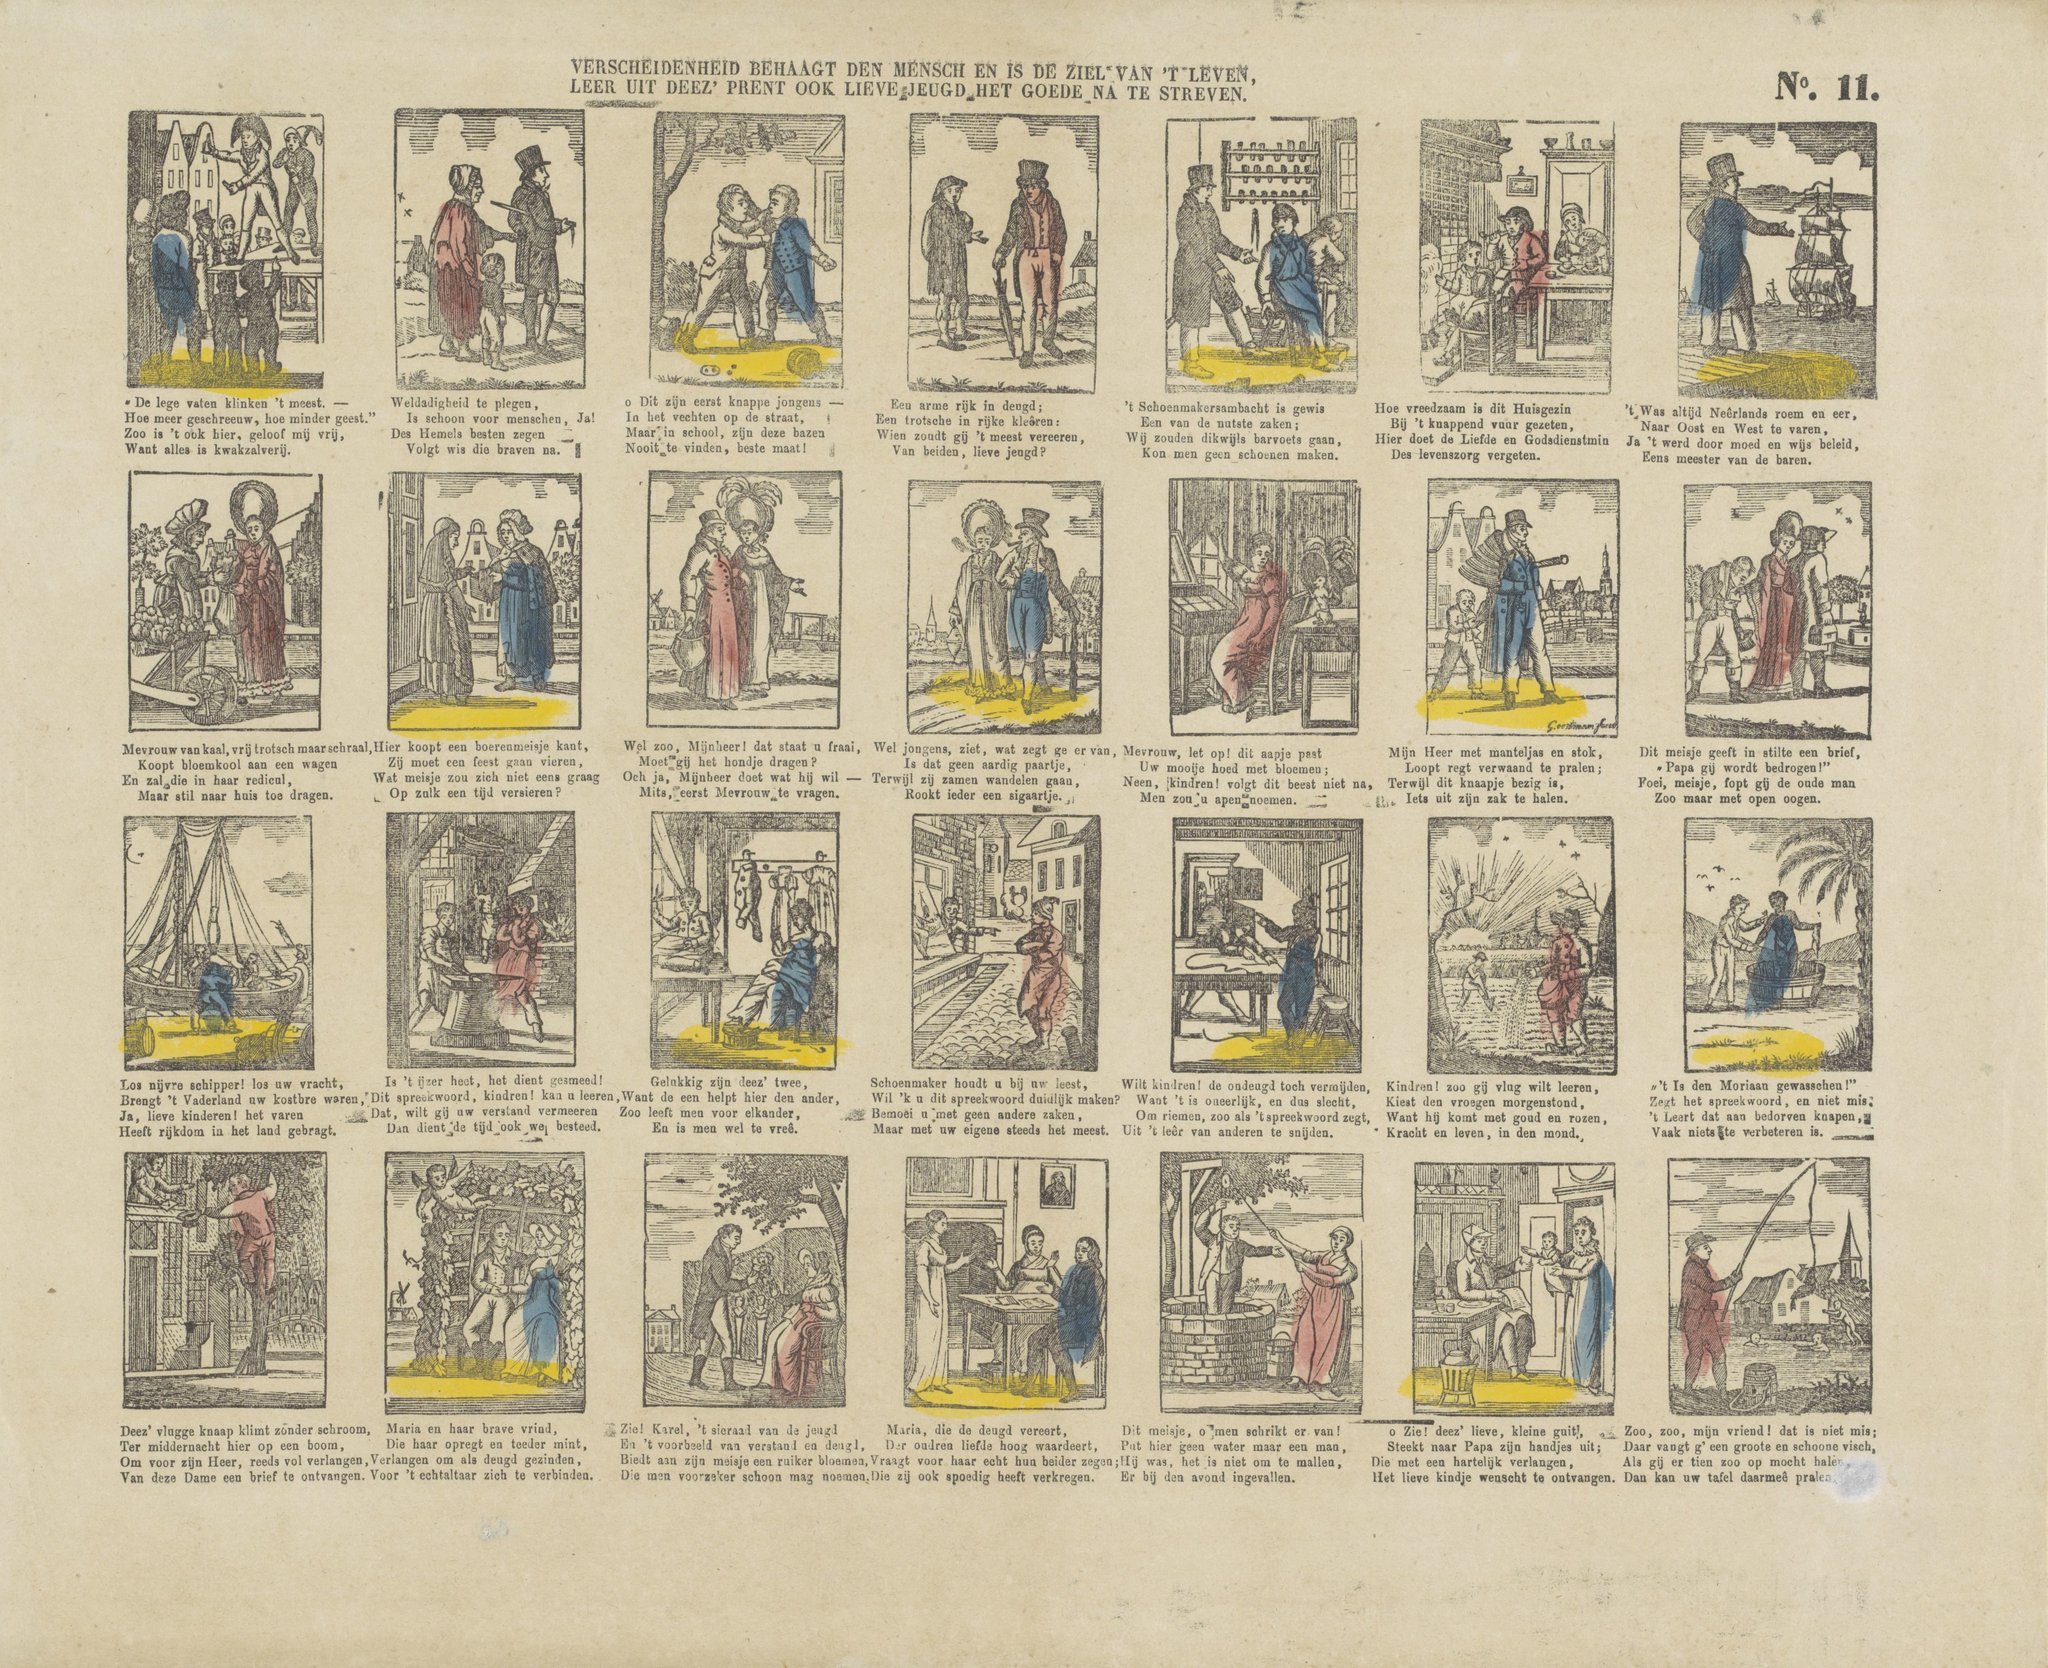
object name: print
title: Verscheidenheid behaagt den mensch / En is de ziel van 't leven, / Leer uit deez' prent ook lieve jeugd, / Het goede na te sneven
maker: gerrit oortman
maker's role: print maker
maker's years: 1781-1822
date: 1850-1870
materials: paper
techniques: colour, letterpress printing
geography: netherlands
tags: craft-production, skilled handiwork, farmers, working class, labourers, crafts and industries, fighting, seaman: sailor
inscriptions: collector's mark: Lugt 2760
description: Blad met 28 voorstellingen van verschillende beroepen en bezigheden. Onder elke voorstelling een vers. Rechtsboven genummerd: No. 11.